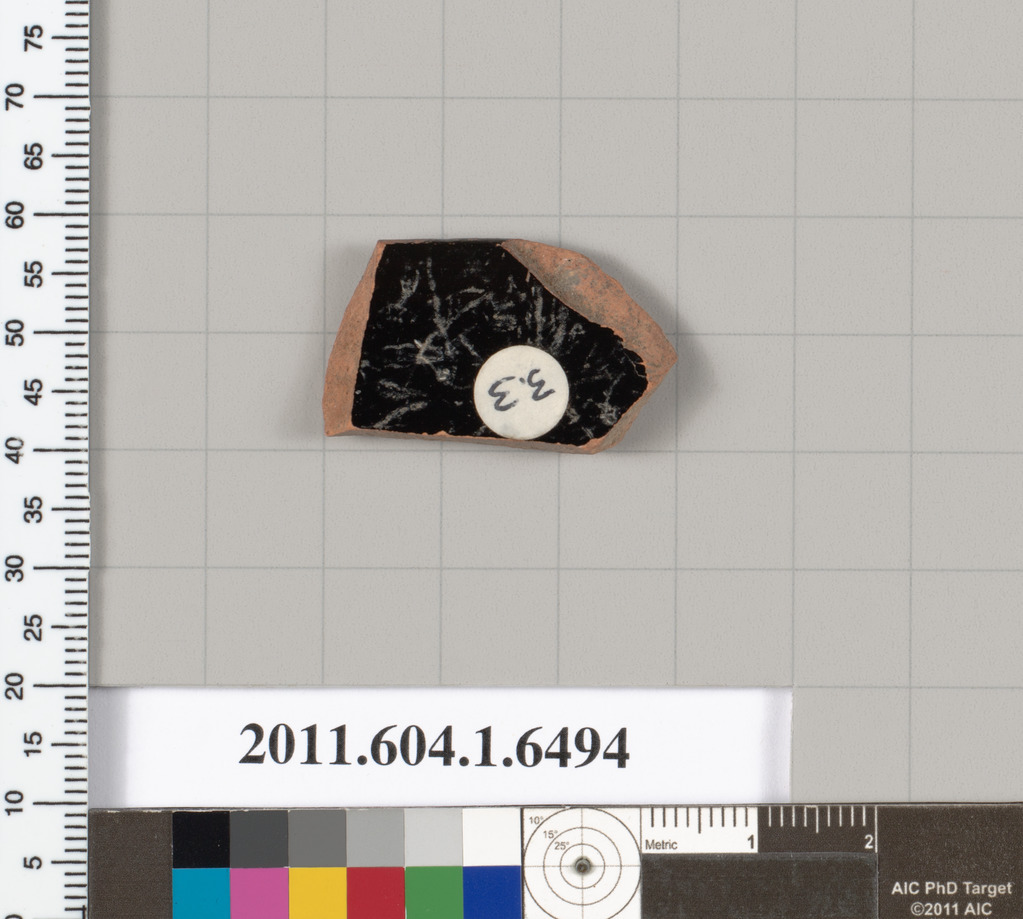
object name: kylix fragment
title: Terracotta fragment of a kylix (drinking cup)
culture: greek, attic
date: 490-480 BCE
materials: terracotta